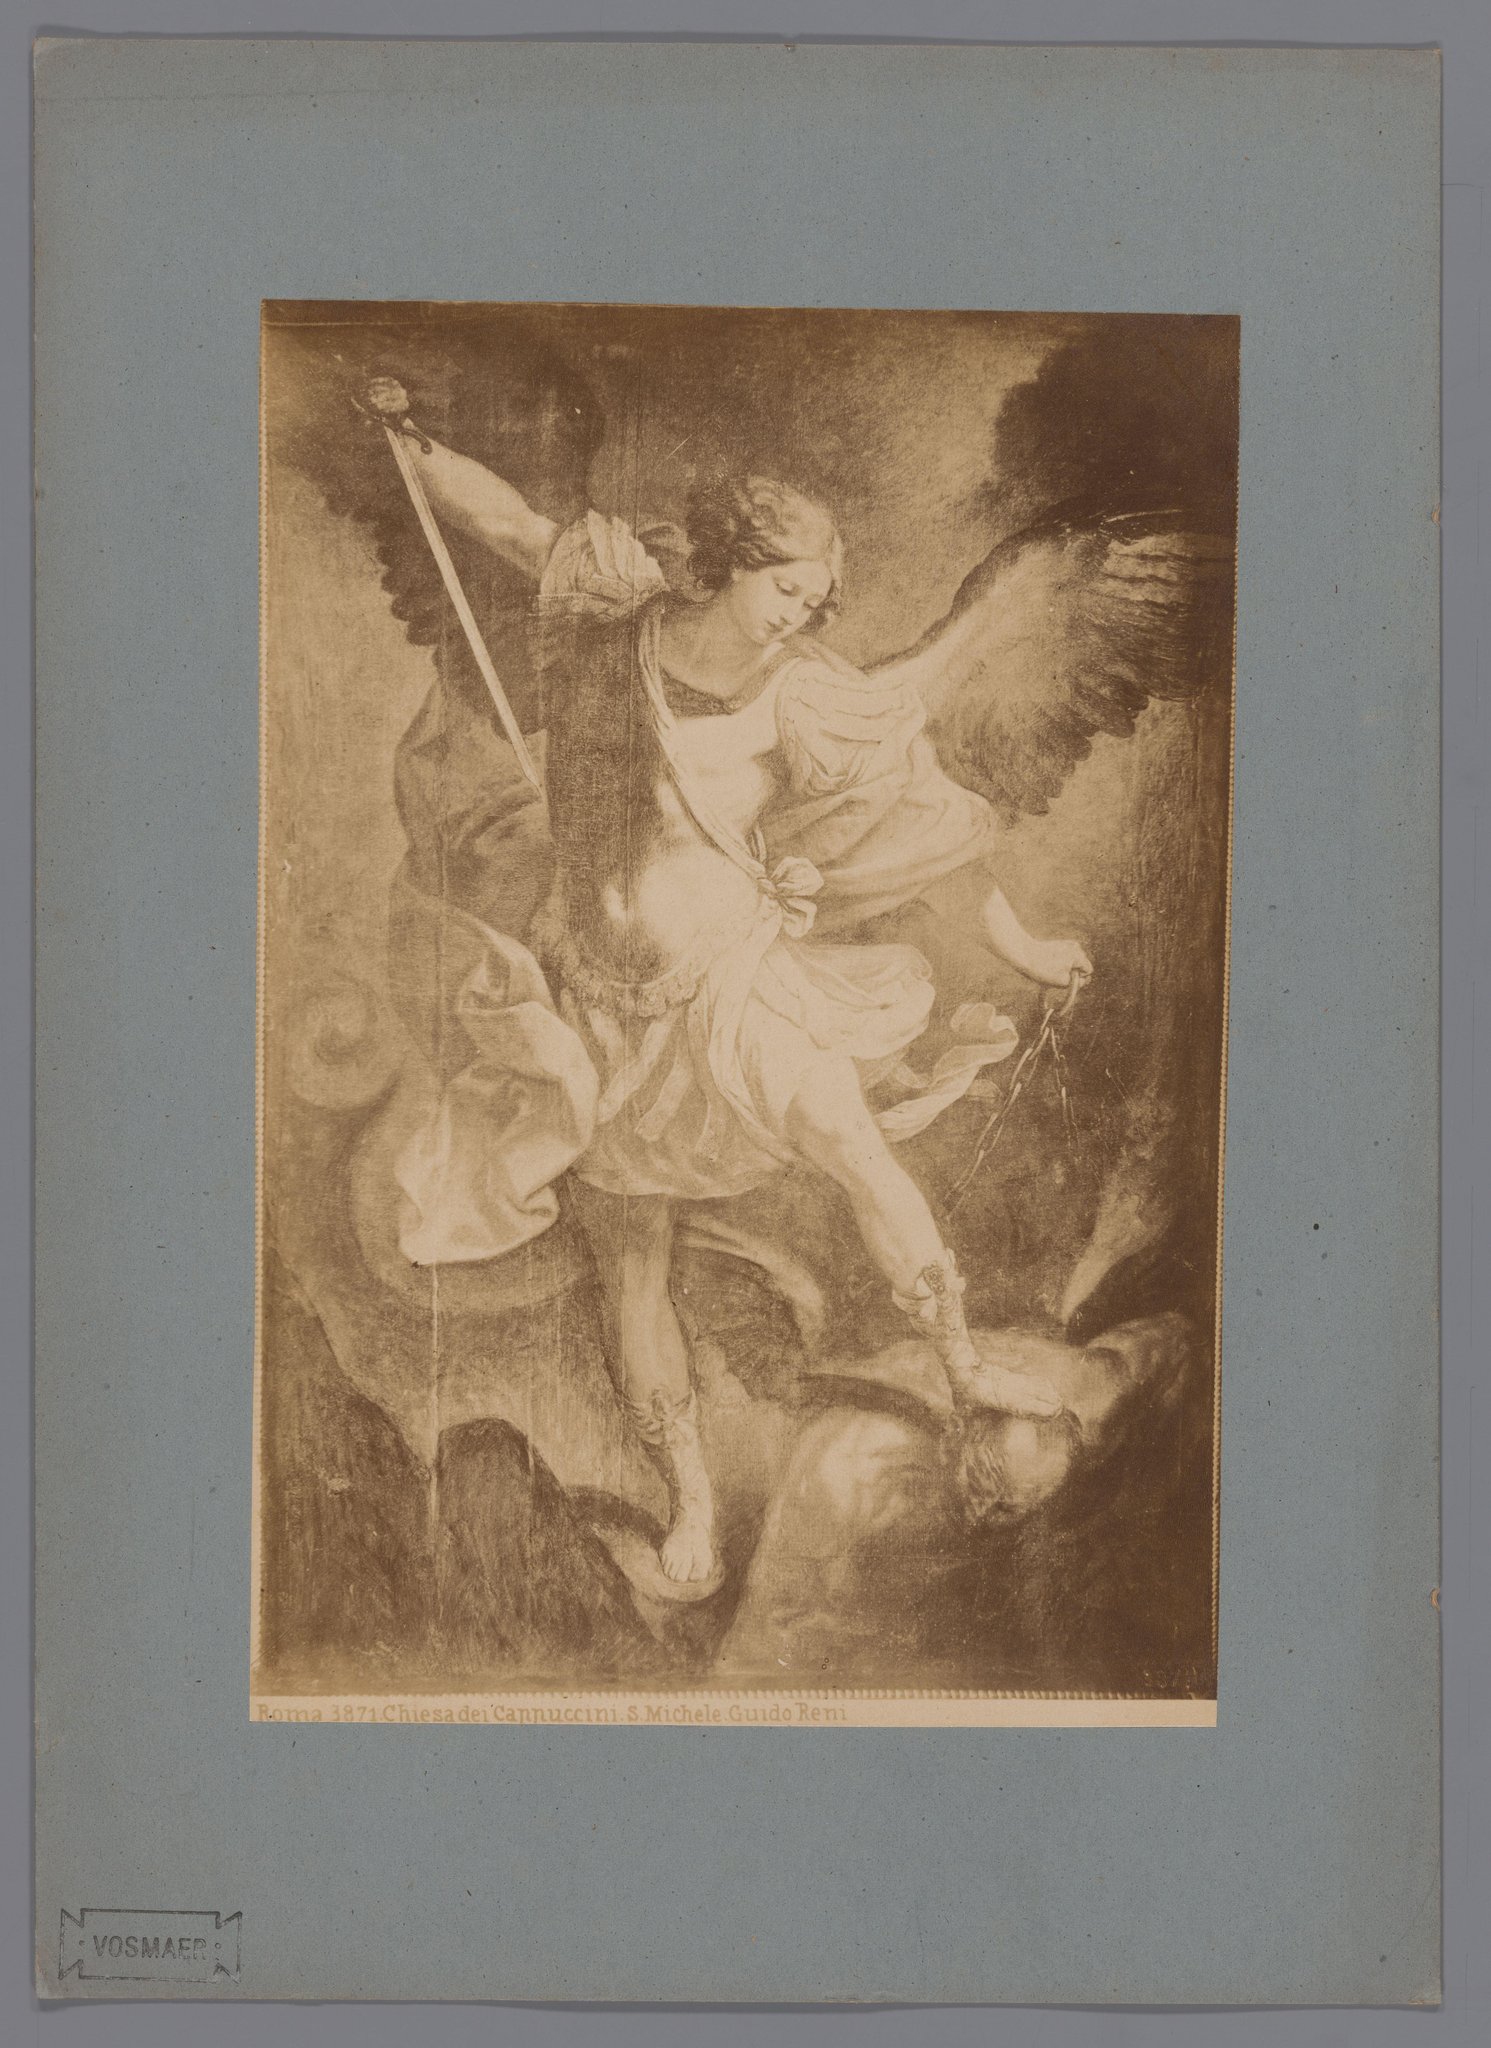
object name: photograph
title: Roma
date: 1851-1900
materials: cardboard, paper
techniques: albumen print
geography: rome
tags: picture, painting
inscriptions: number: ‘3871.’, collector's mark: ‘VOSMAER’